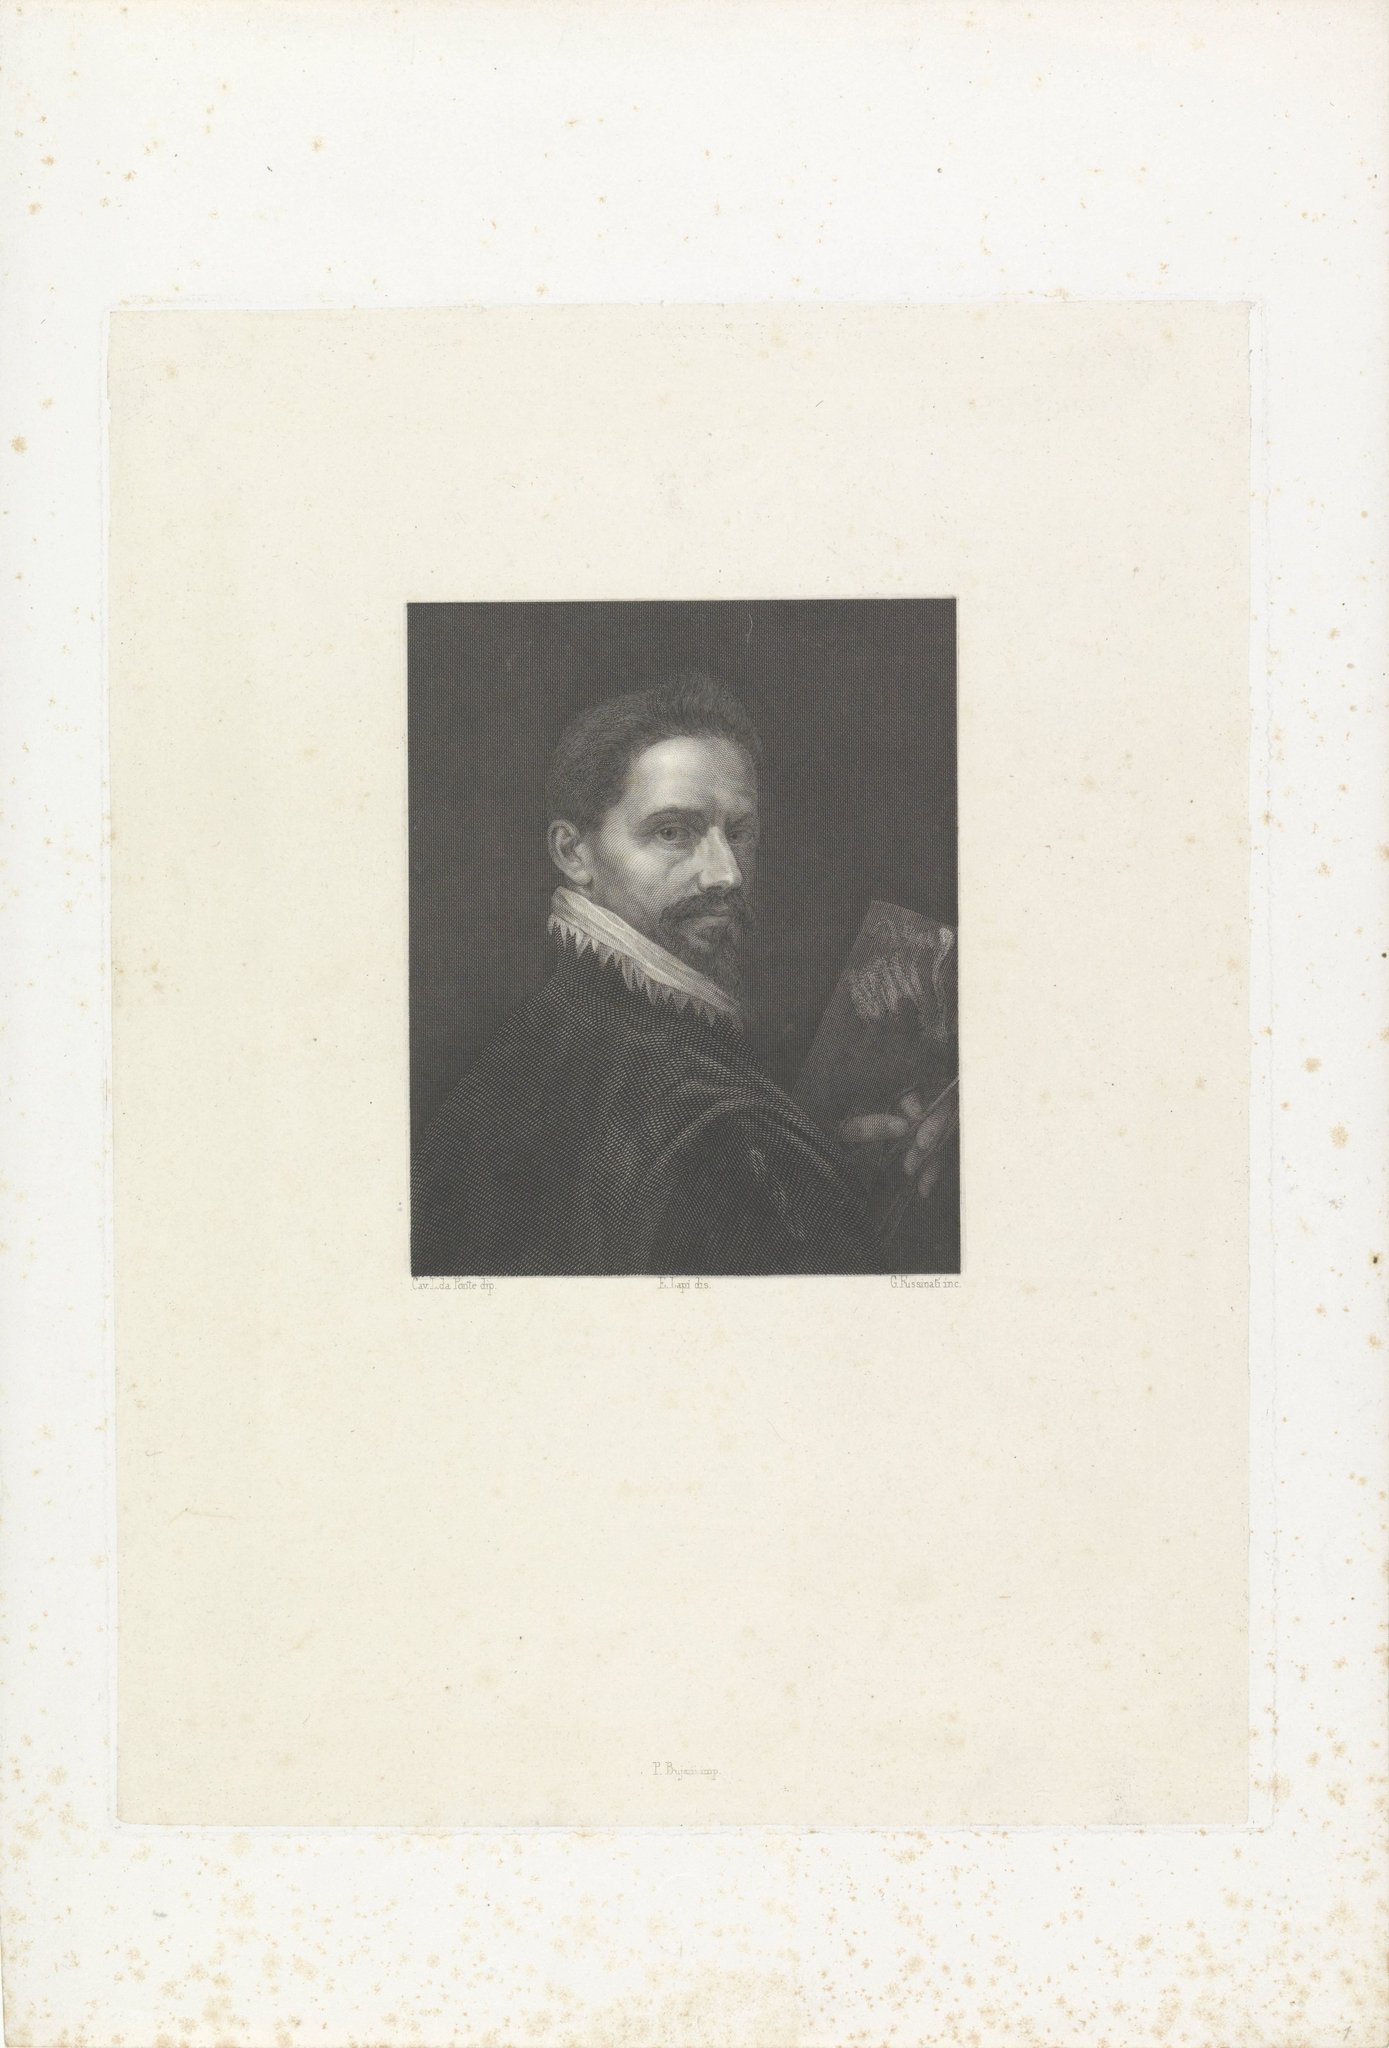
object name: print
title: Portret van schilder Leandro Bassano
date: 1813-1883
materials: paper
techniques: engraving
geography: italy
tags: draughtsman, leandro bassano, historical persons, portrait, self-portrait of painter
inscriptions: collector's mark, collector's mark: Lugt 2228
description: Naar een geschilderd zelfportret door Leandro Bassano in de Vasari Corridor, Galleria degli Uffizi te Florence.